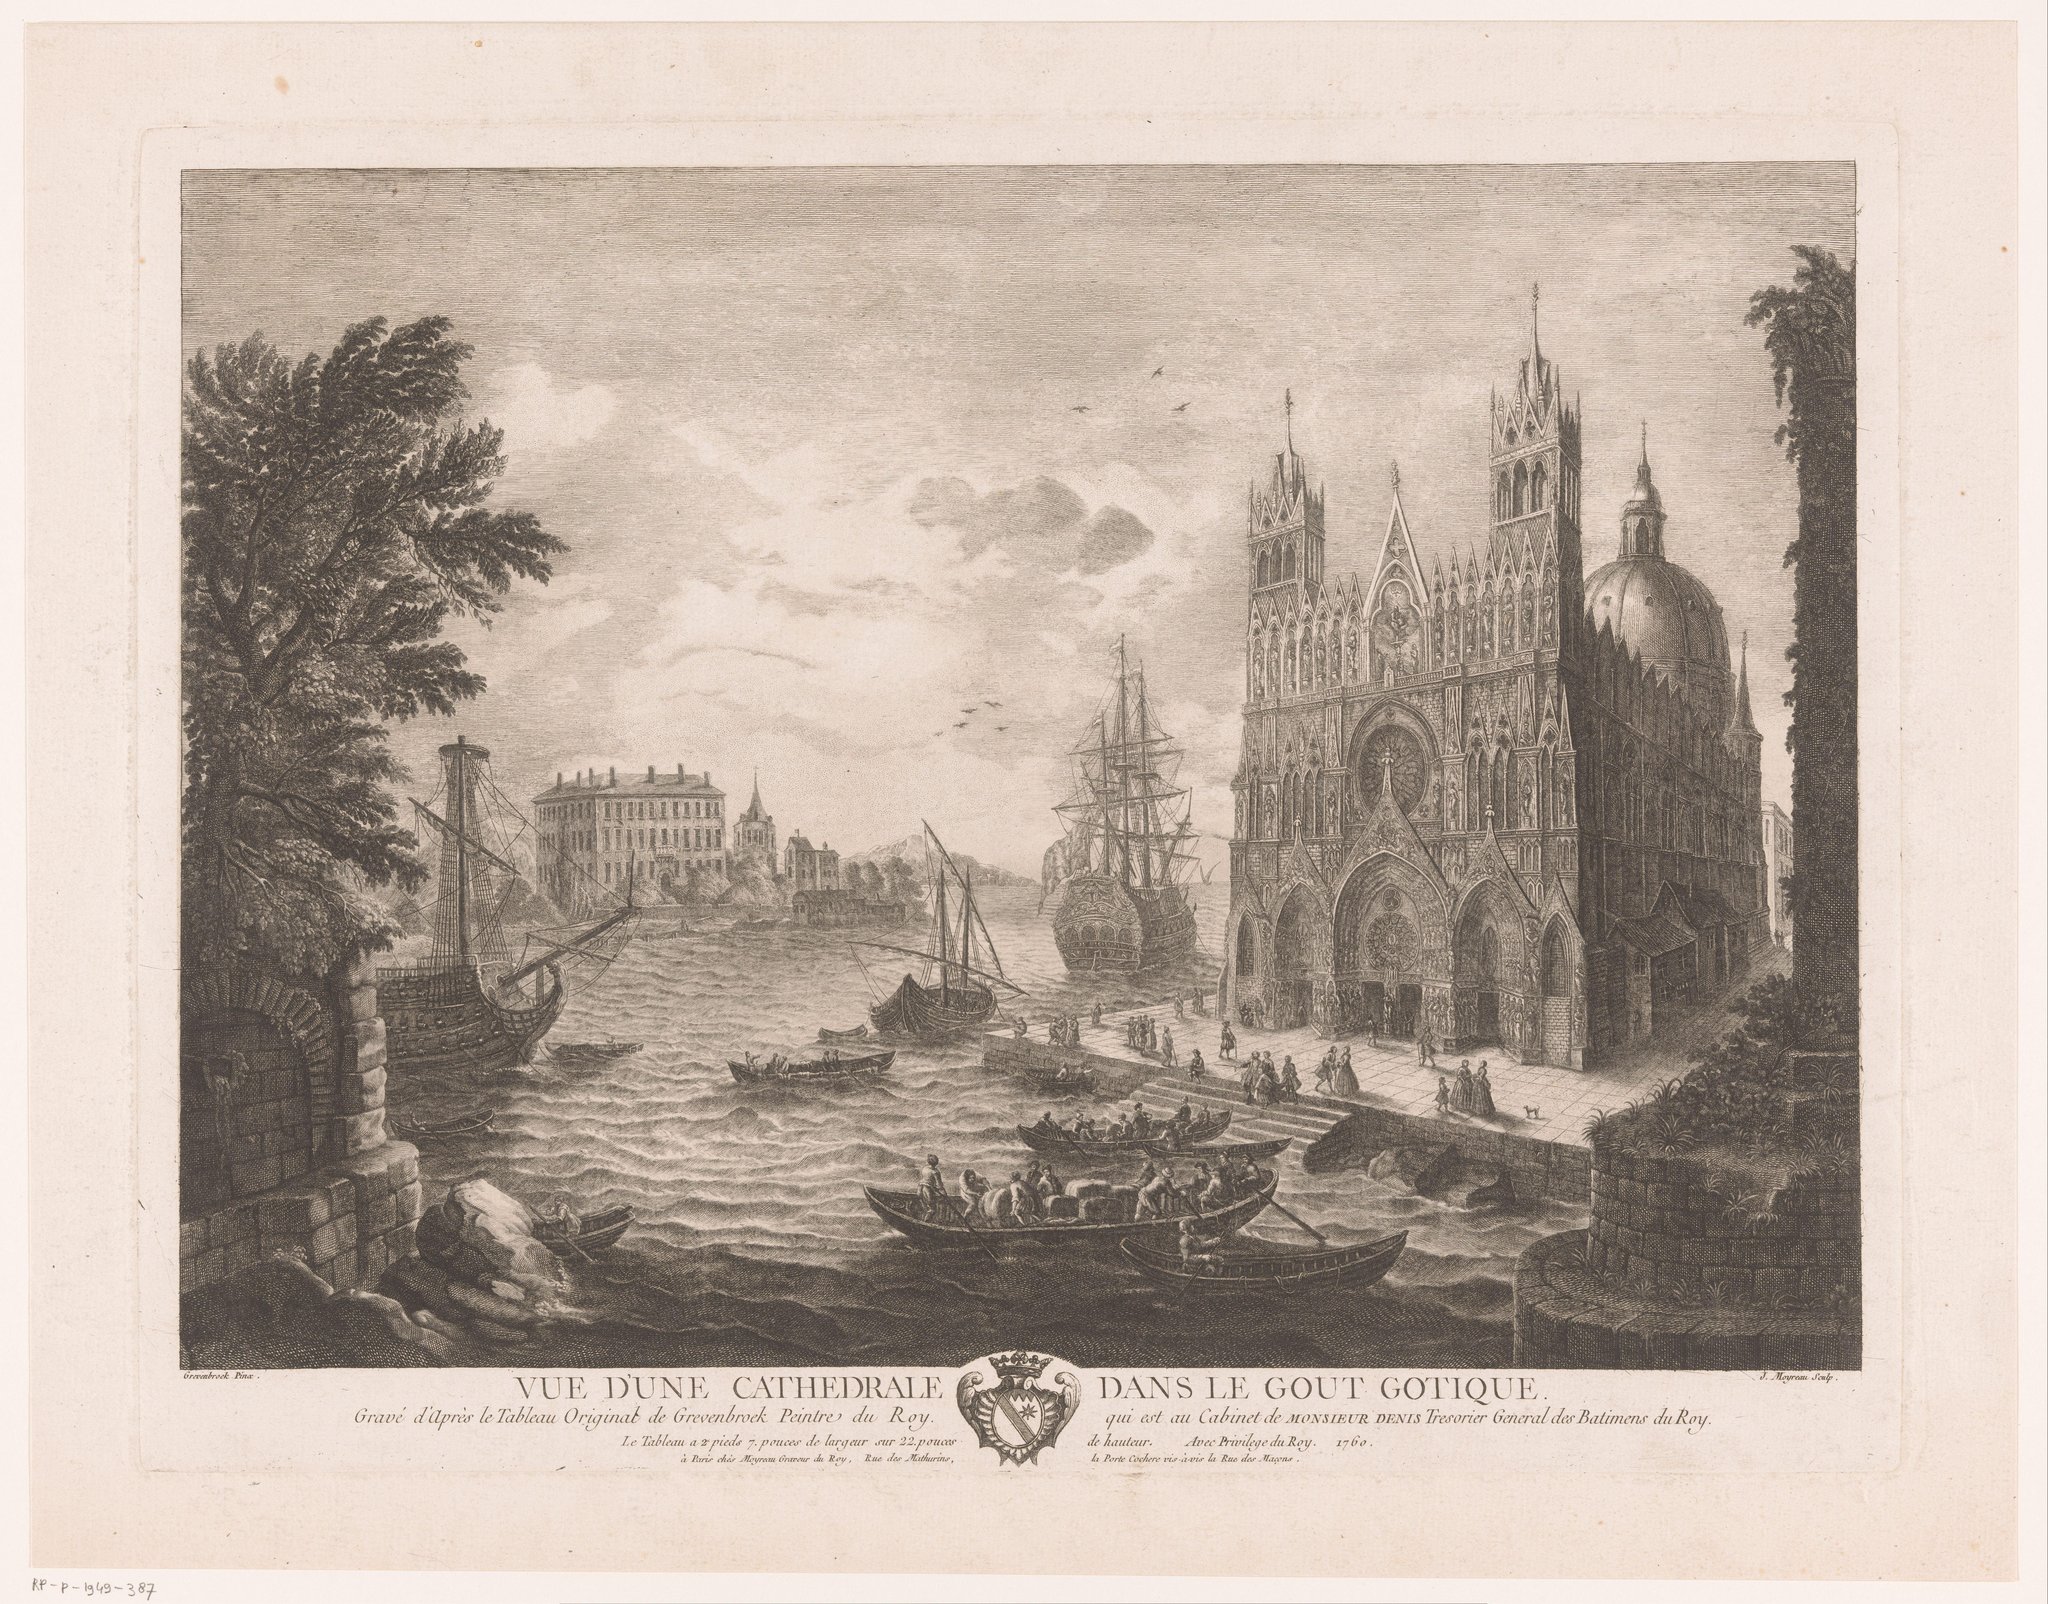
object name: print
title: Gezicht op een kathedraal in een havenstad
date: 1760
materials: paper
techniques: engraving, etching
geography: paris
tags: harbour, church (exterior)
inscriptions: collector's mark: Lugt 2228